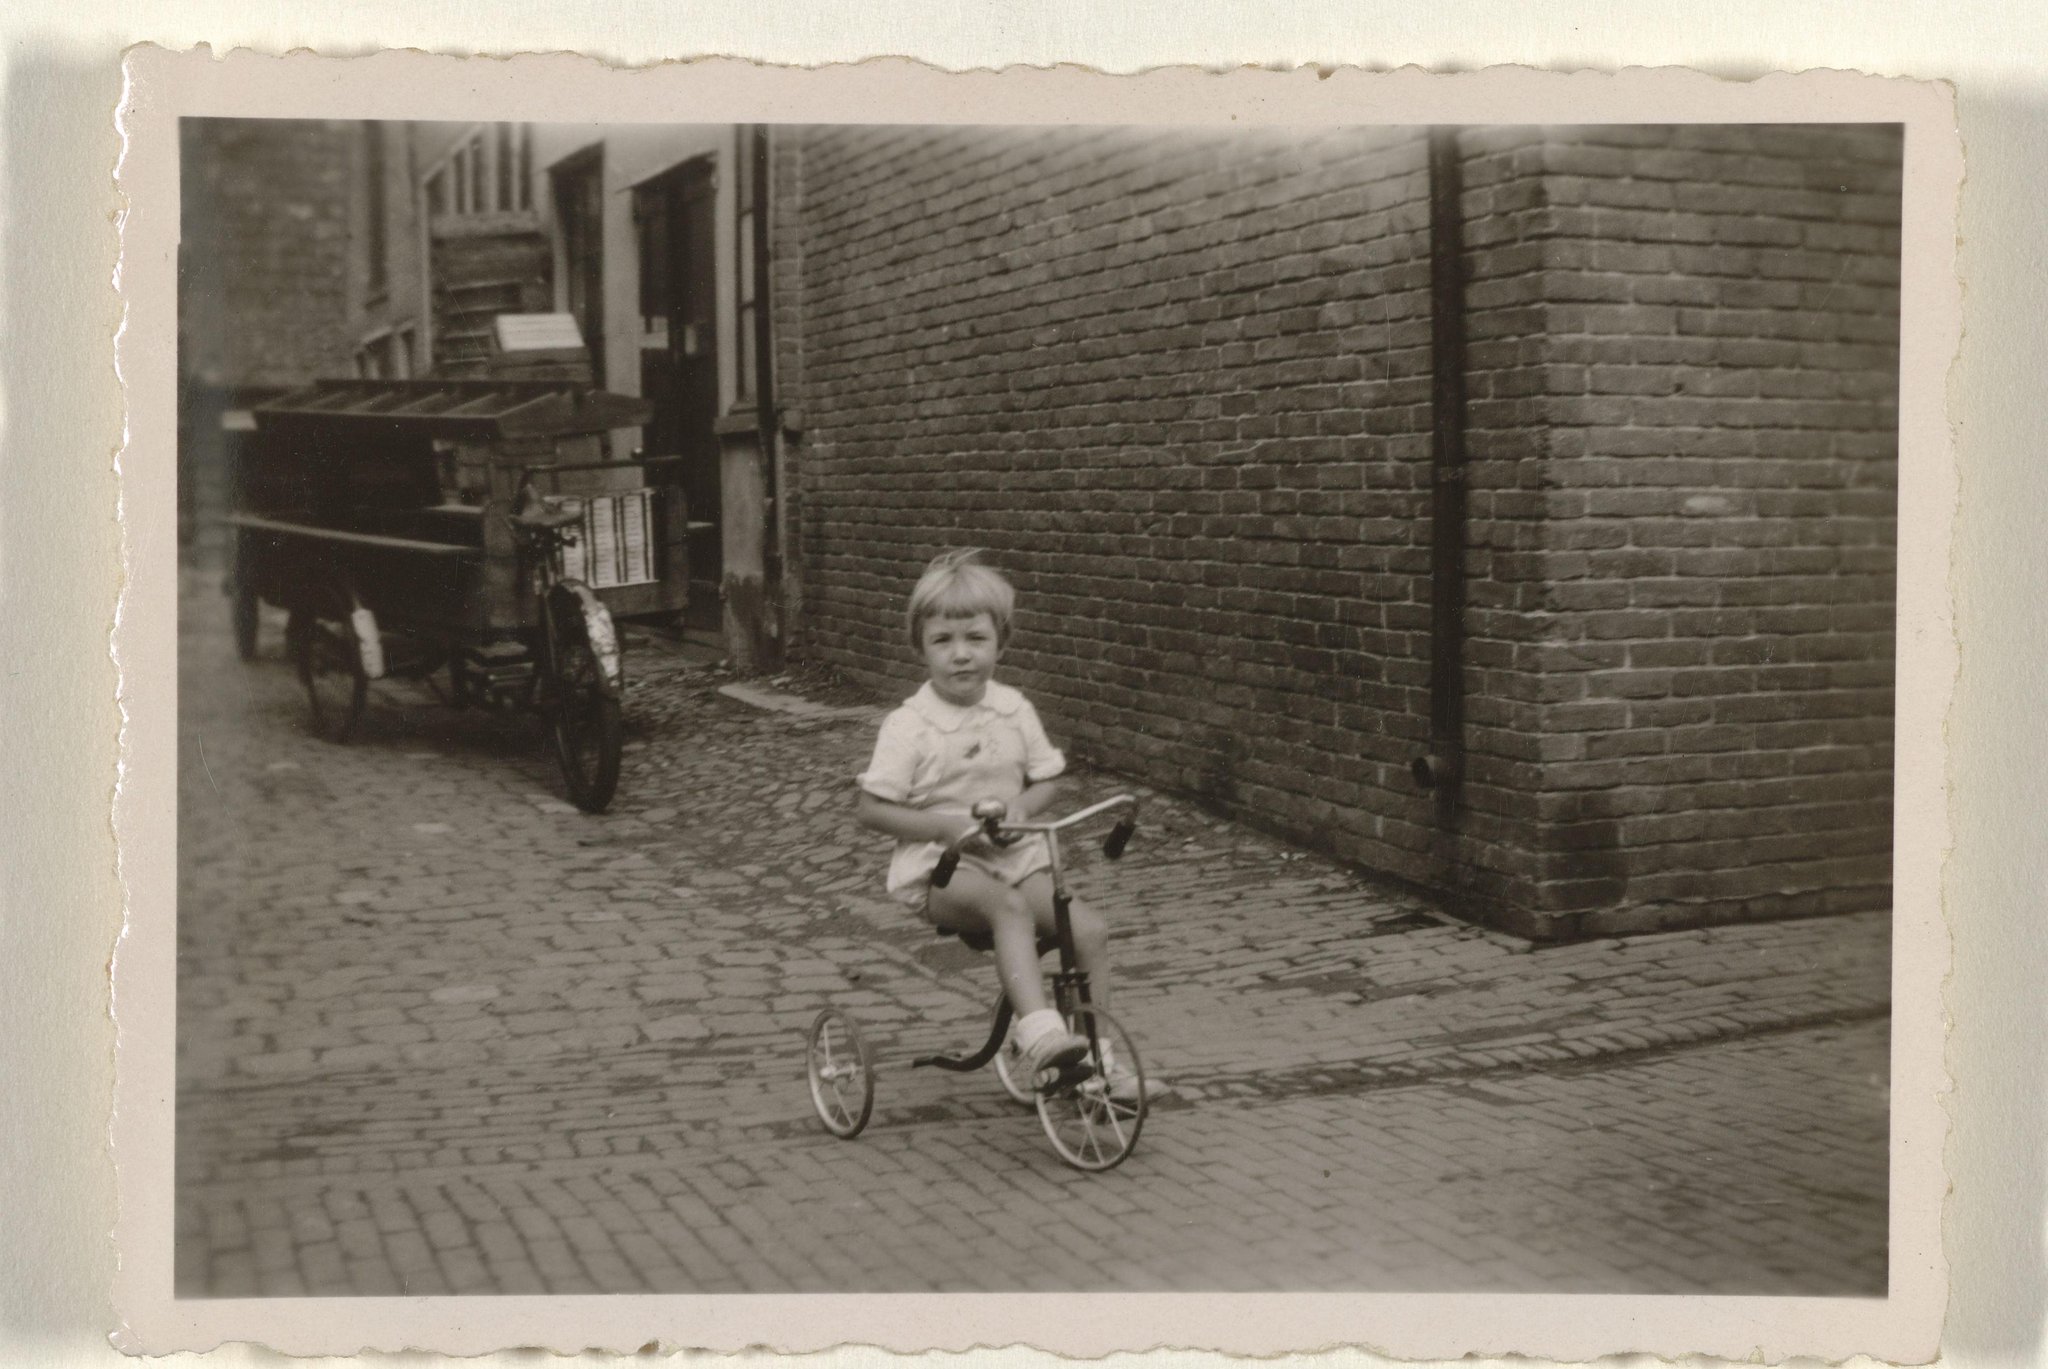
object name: photograph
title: Meisje op een driewieler op straat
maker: Anonymous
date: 1925-1950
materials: paper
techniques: gelatin silver print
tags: tricycle, girl (child between toddler and youth)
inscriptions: number: ‘3406’, inscription: ‘AQ’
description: Portret van een klein meisje op een driewieler op straat.